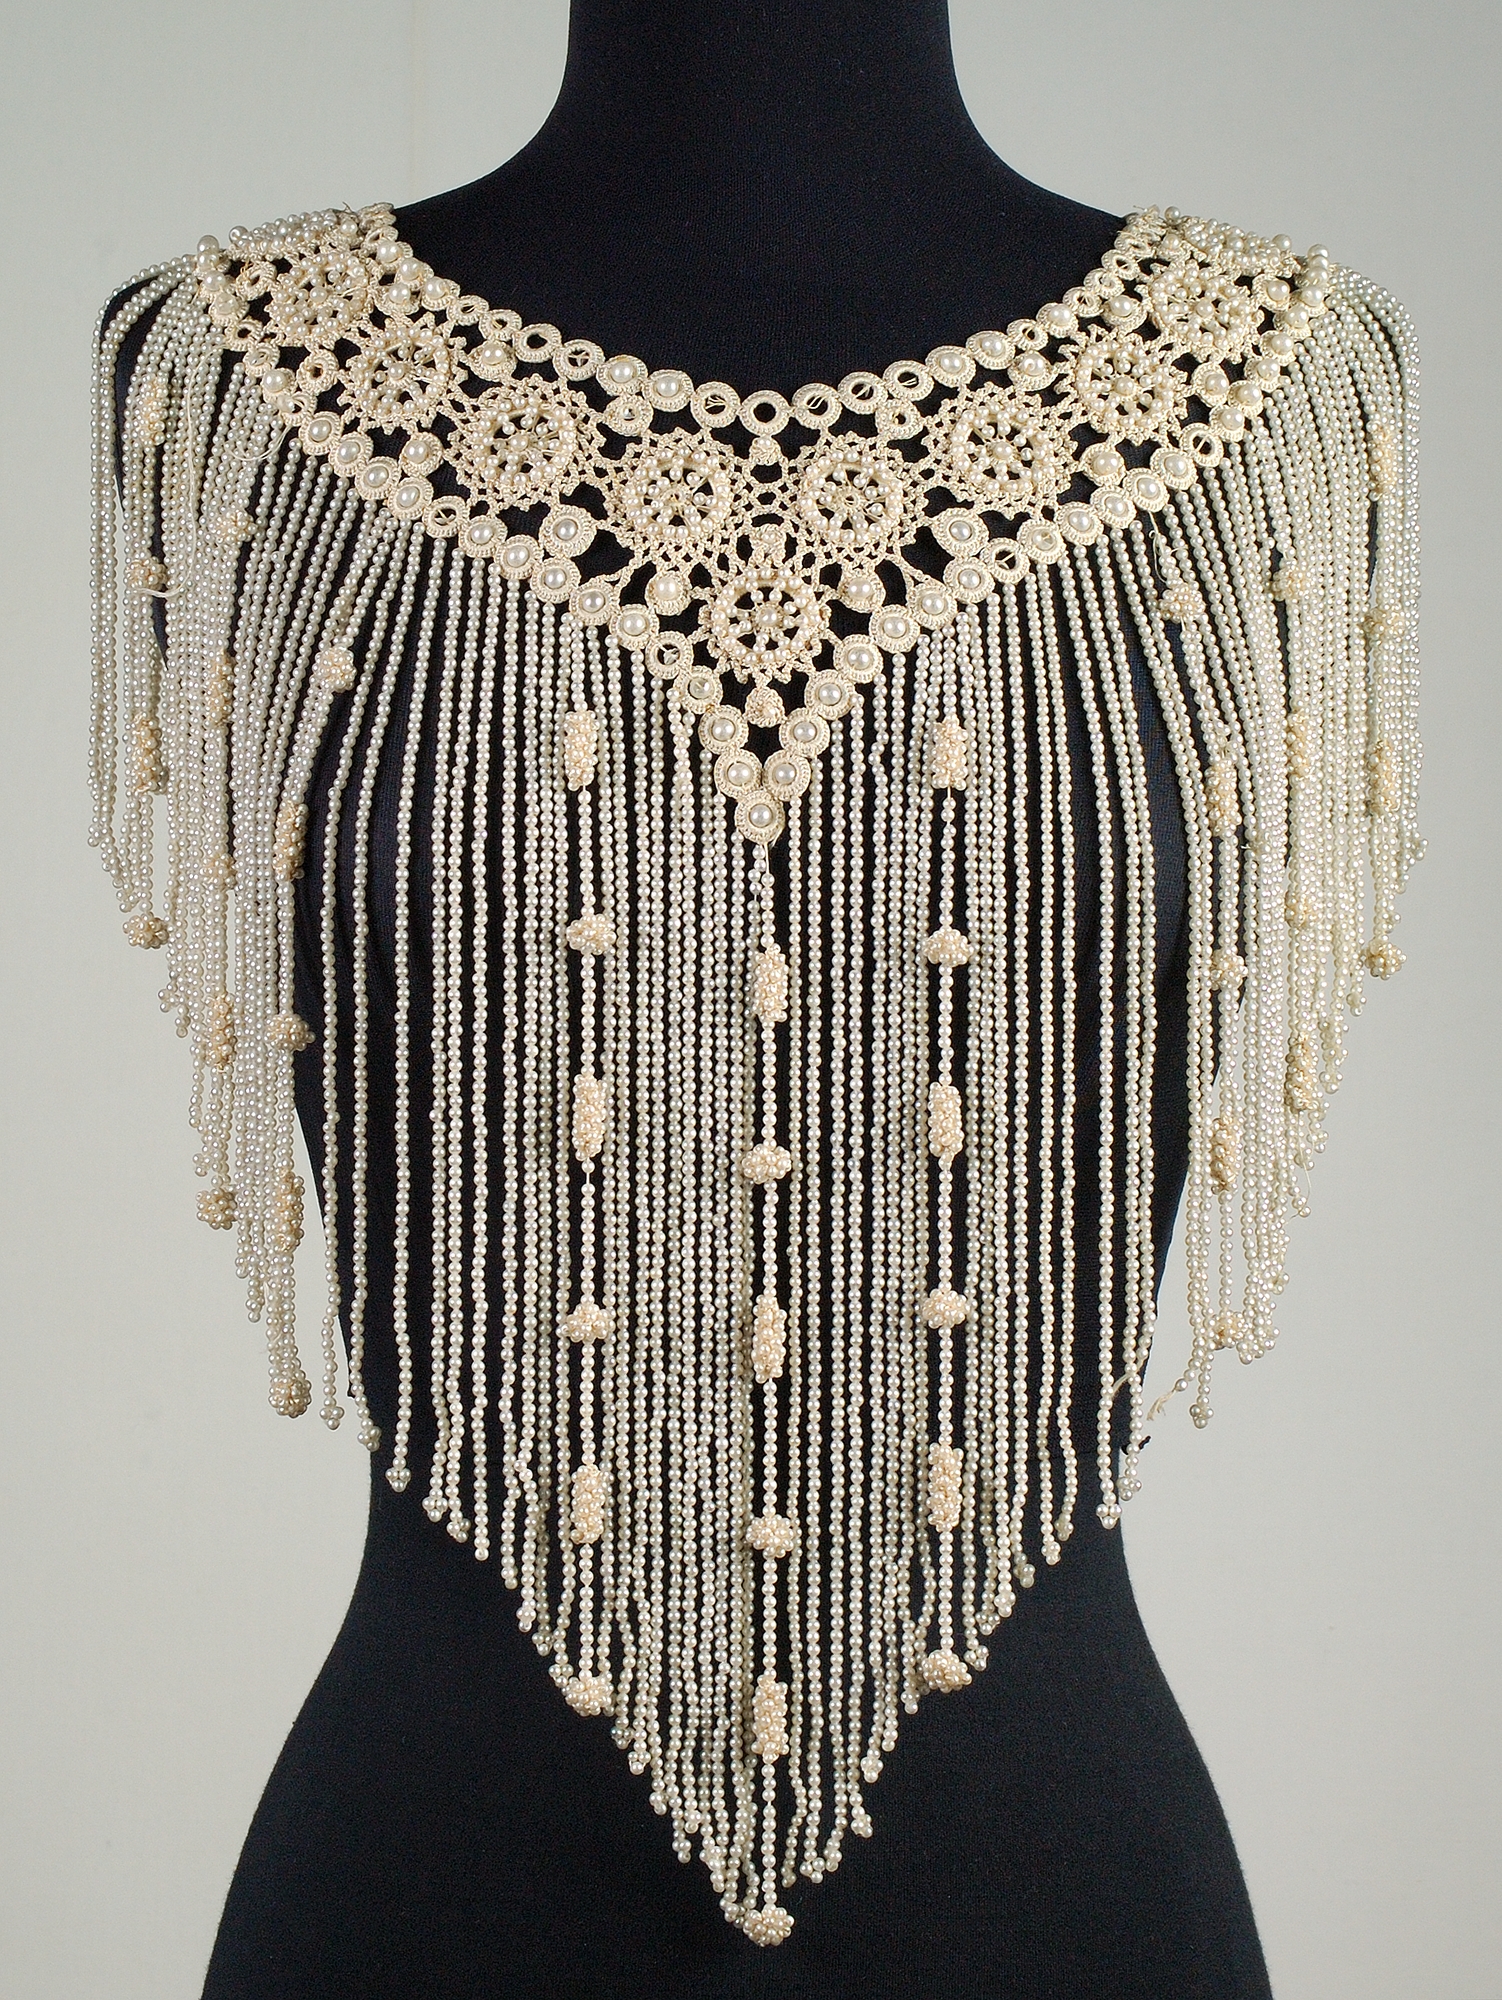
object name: collar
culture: french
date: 1892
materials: linen, silk